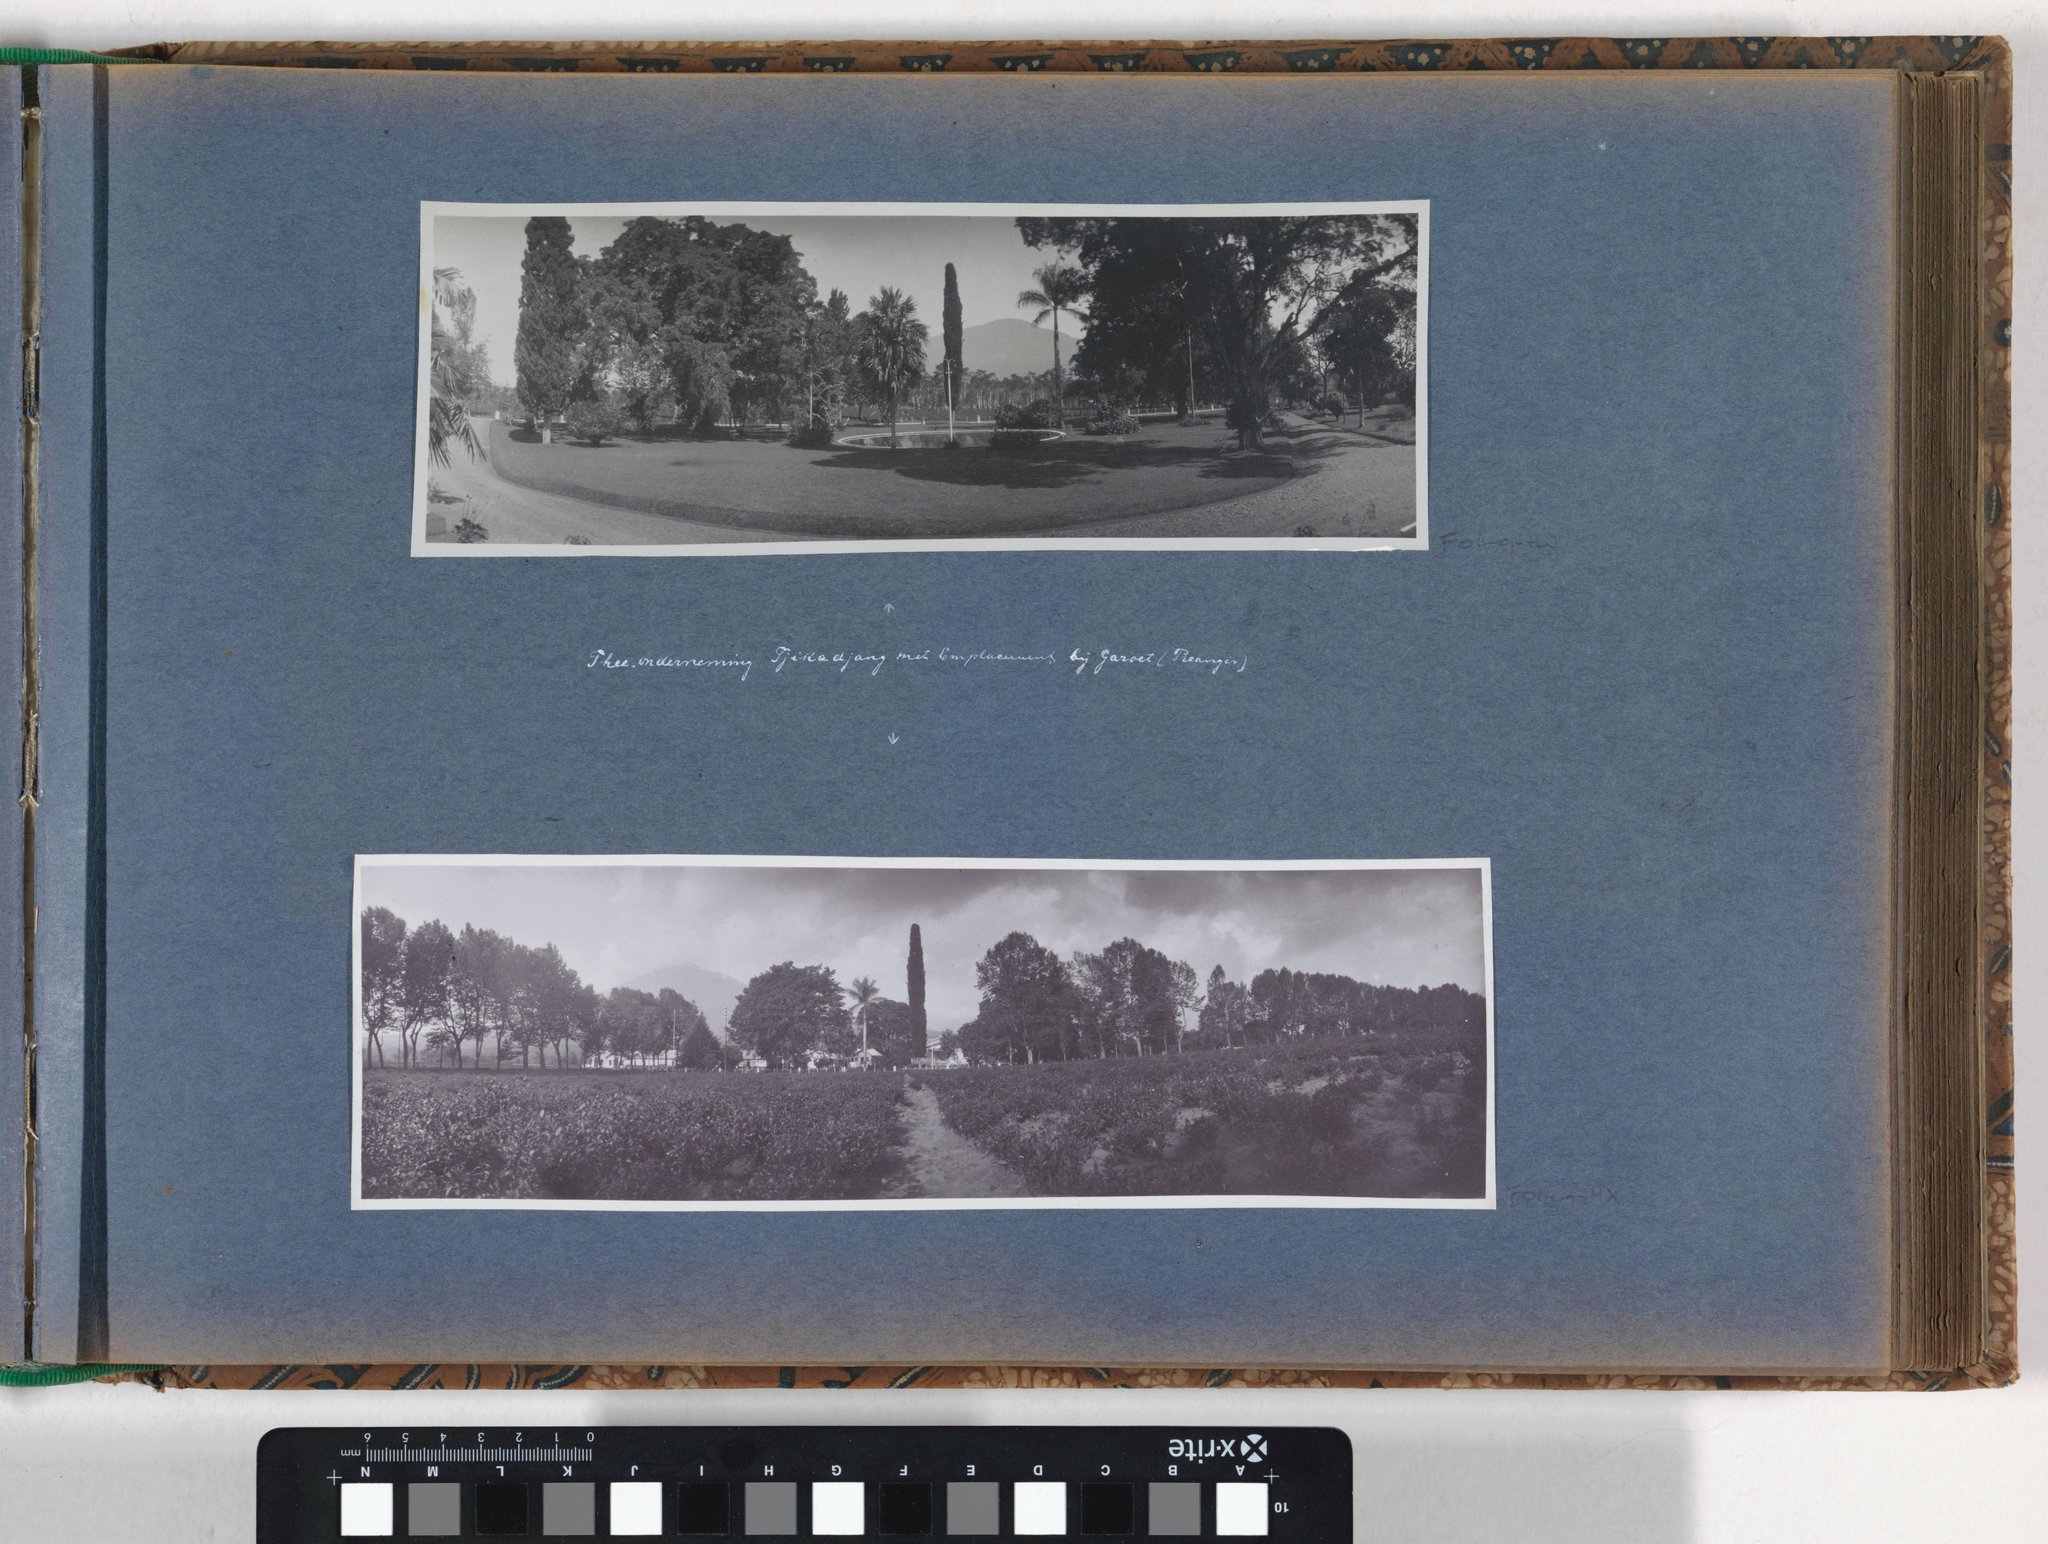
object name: album leaf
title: Thee-onderneming Tjikadjang bij Garvet in Preanger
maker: Anonymous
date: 1900-1920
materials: paper, photographic support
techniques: gelatin silver print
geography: preanger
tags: plantation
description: Onderdeel van reisalbum met foto's van bedrijvigheid en bezienswaardigheden op Sumatra en Java en van de reis naar en van Nederlands-Indië.